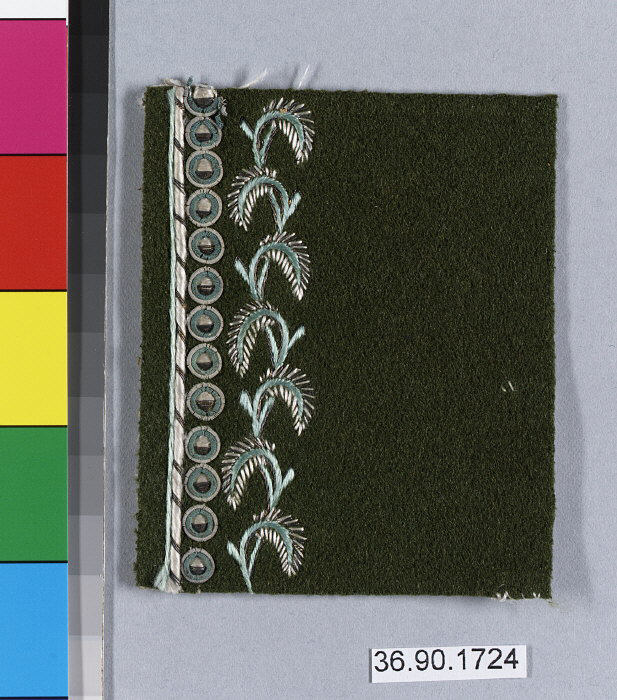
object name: sample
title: Embroidery sample for a man’s suit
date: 1785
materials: metal thread, silk, wool